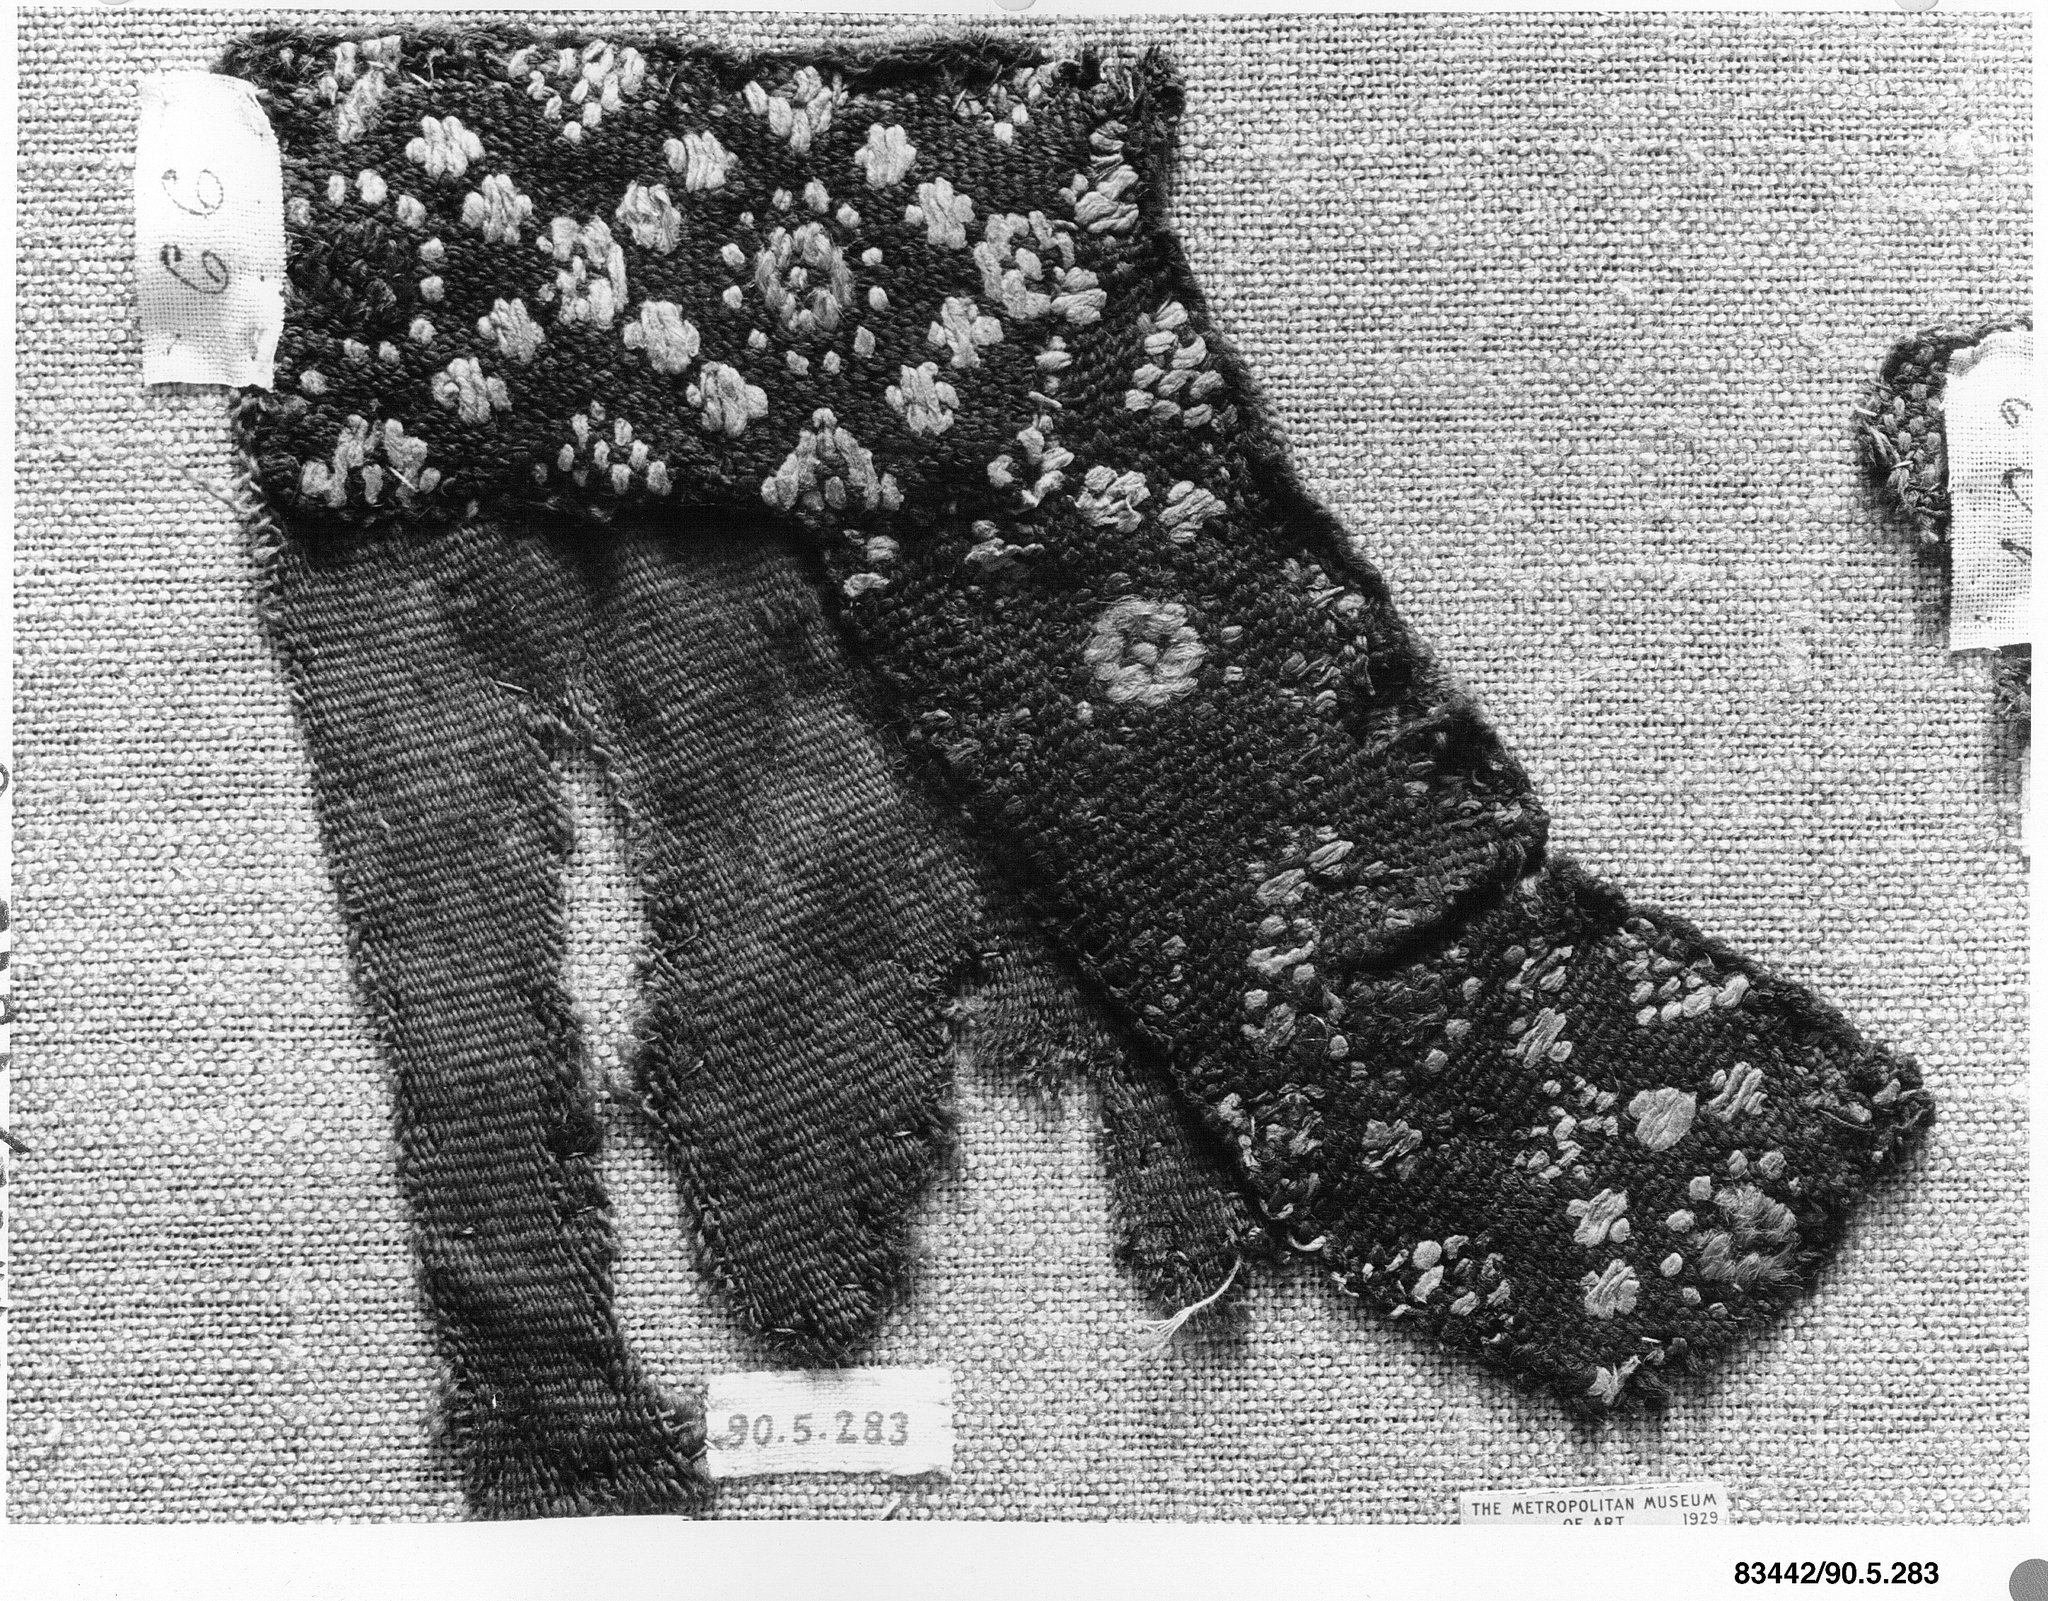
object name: textile fragment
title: Fragment of a Border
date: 401-600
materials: linen, wool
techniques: weave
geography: egypt